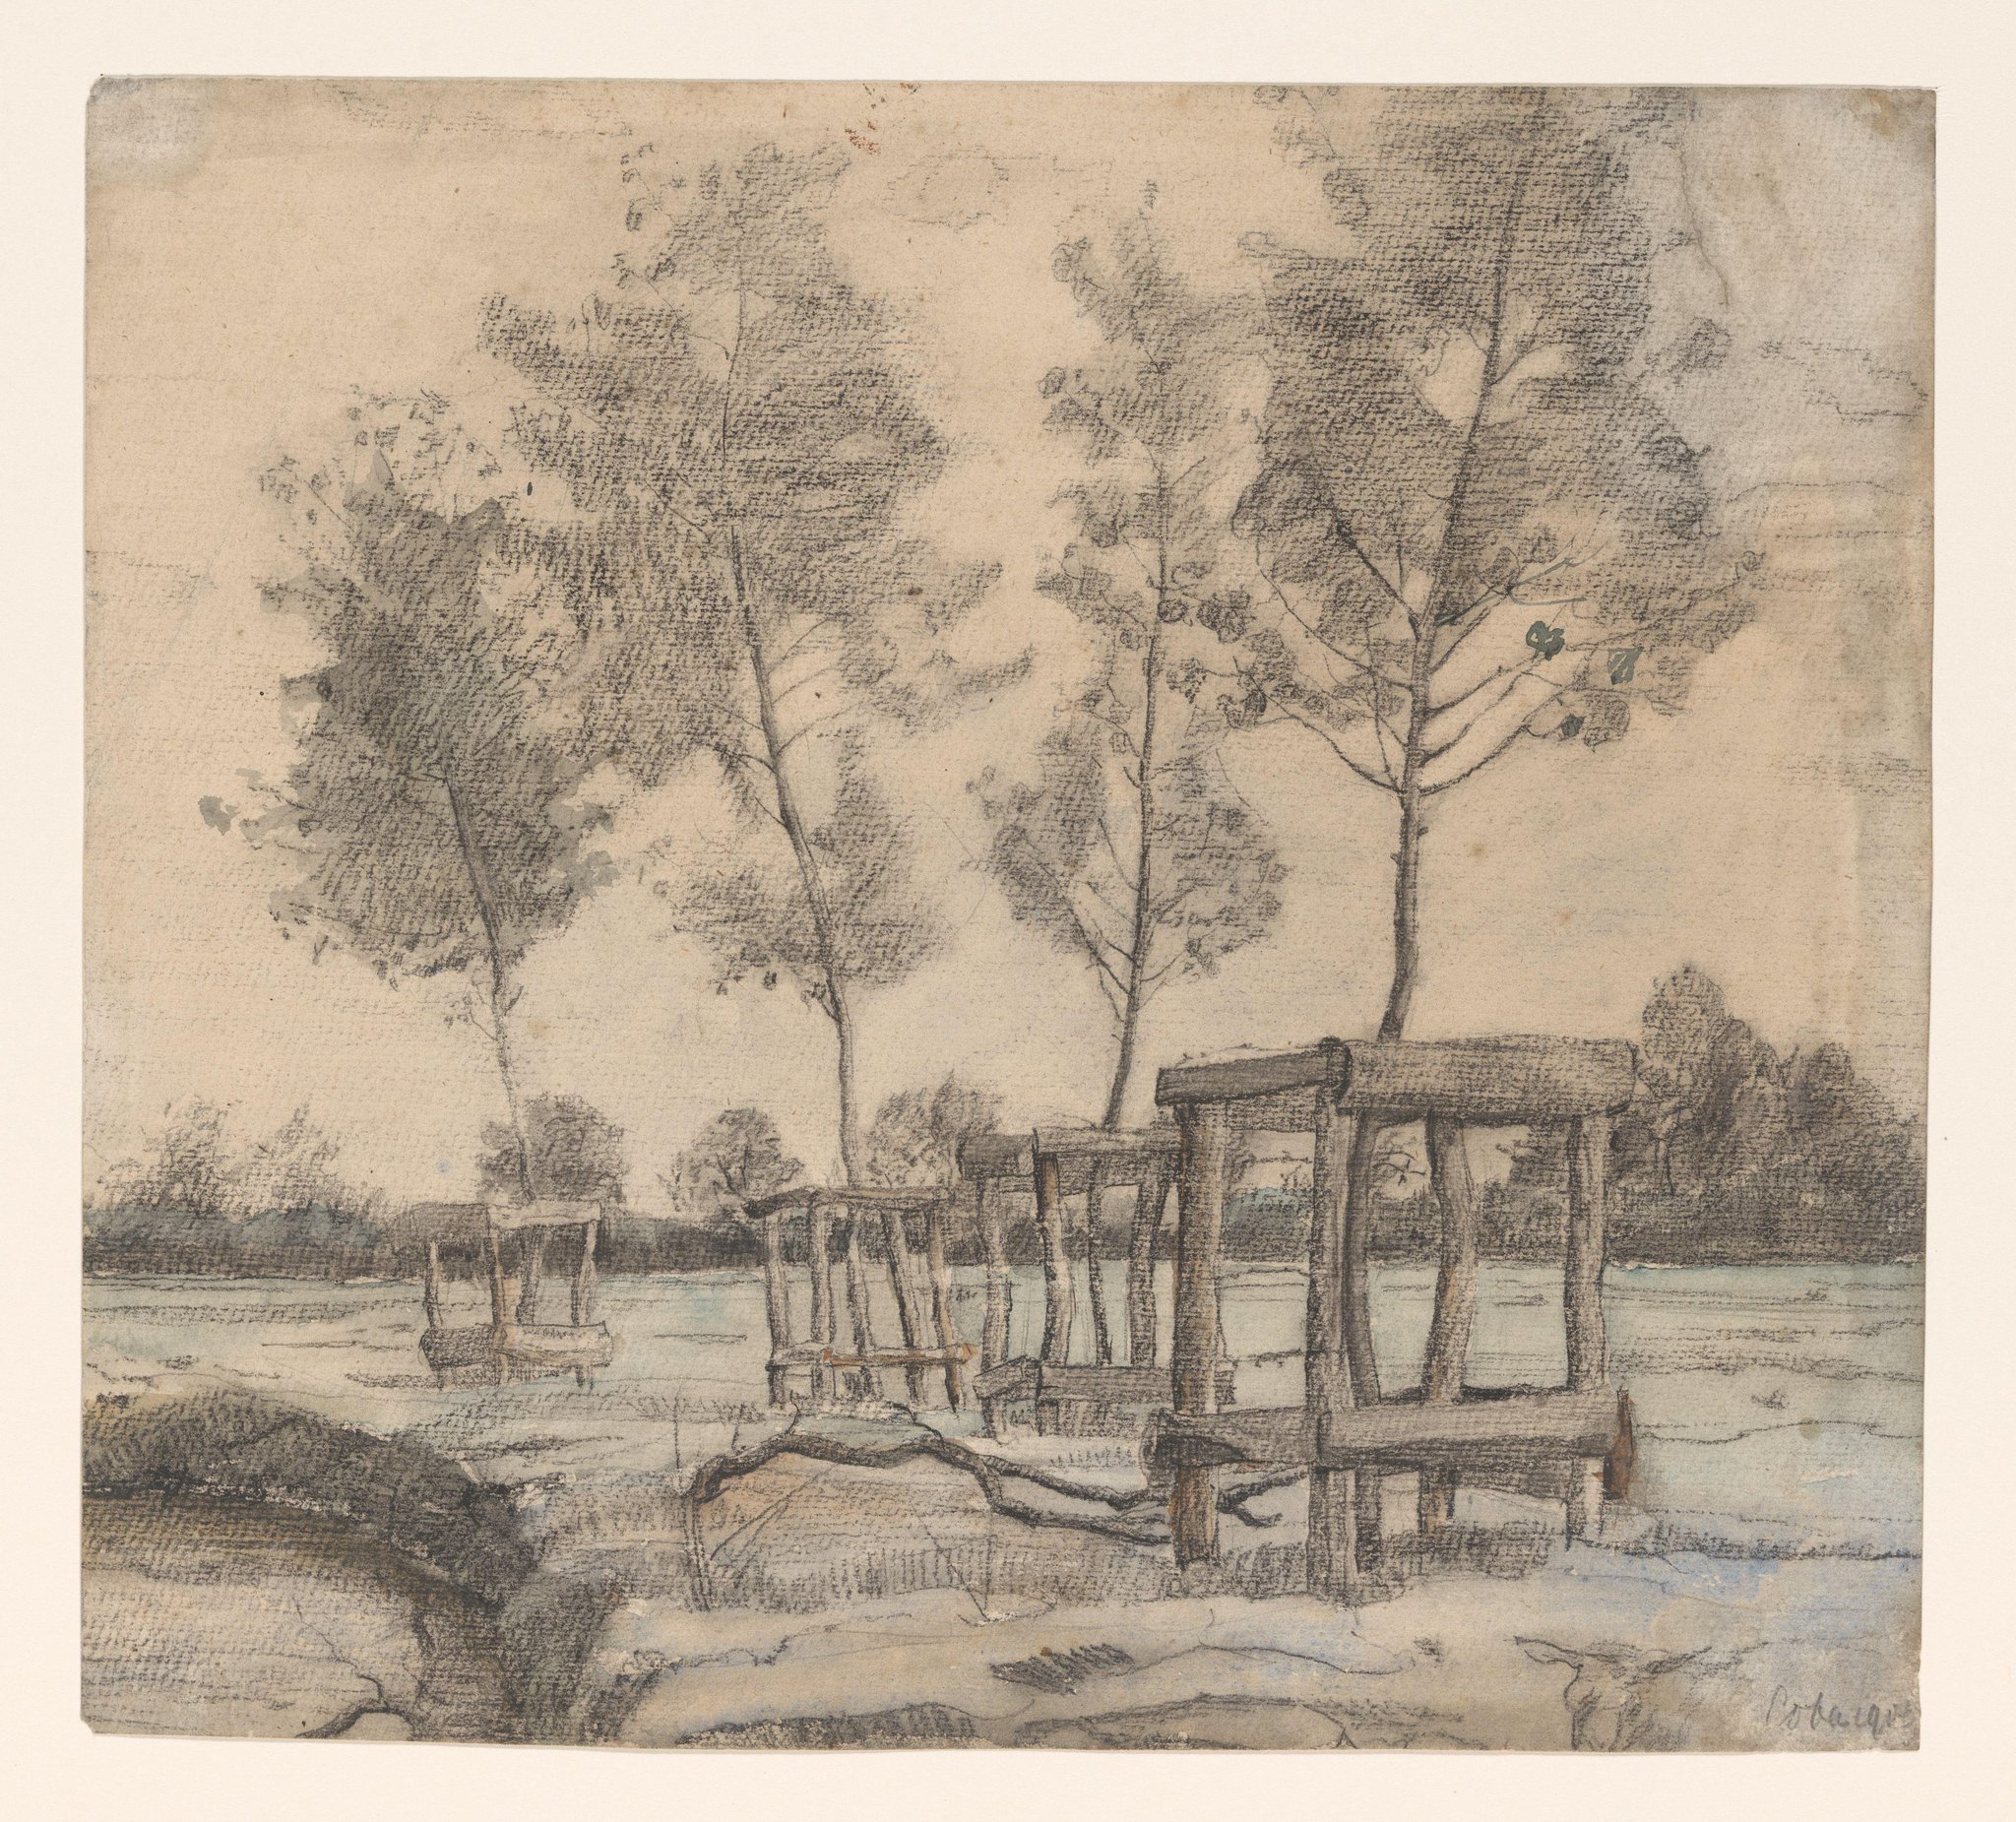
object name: drawing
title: Weiland met bomen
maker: coba steenhoff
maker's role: draughtsman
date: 1800-1900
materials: chalk, paper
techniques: brush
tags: meadow, pasture